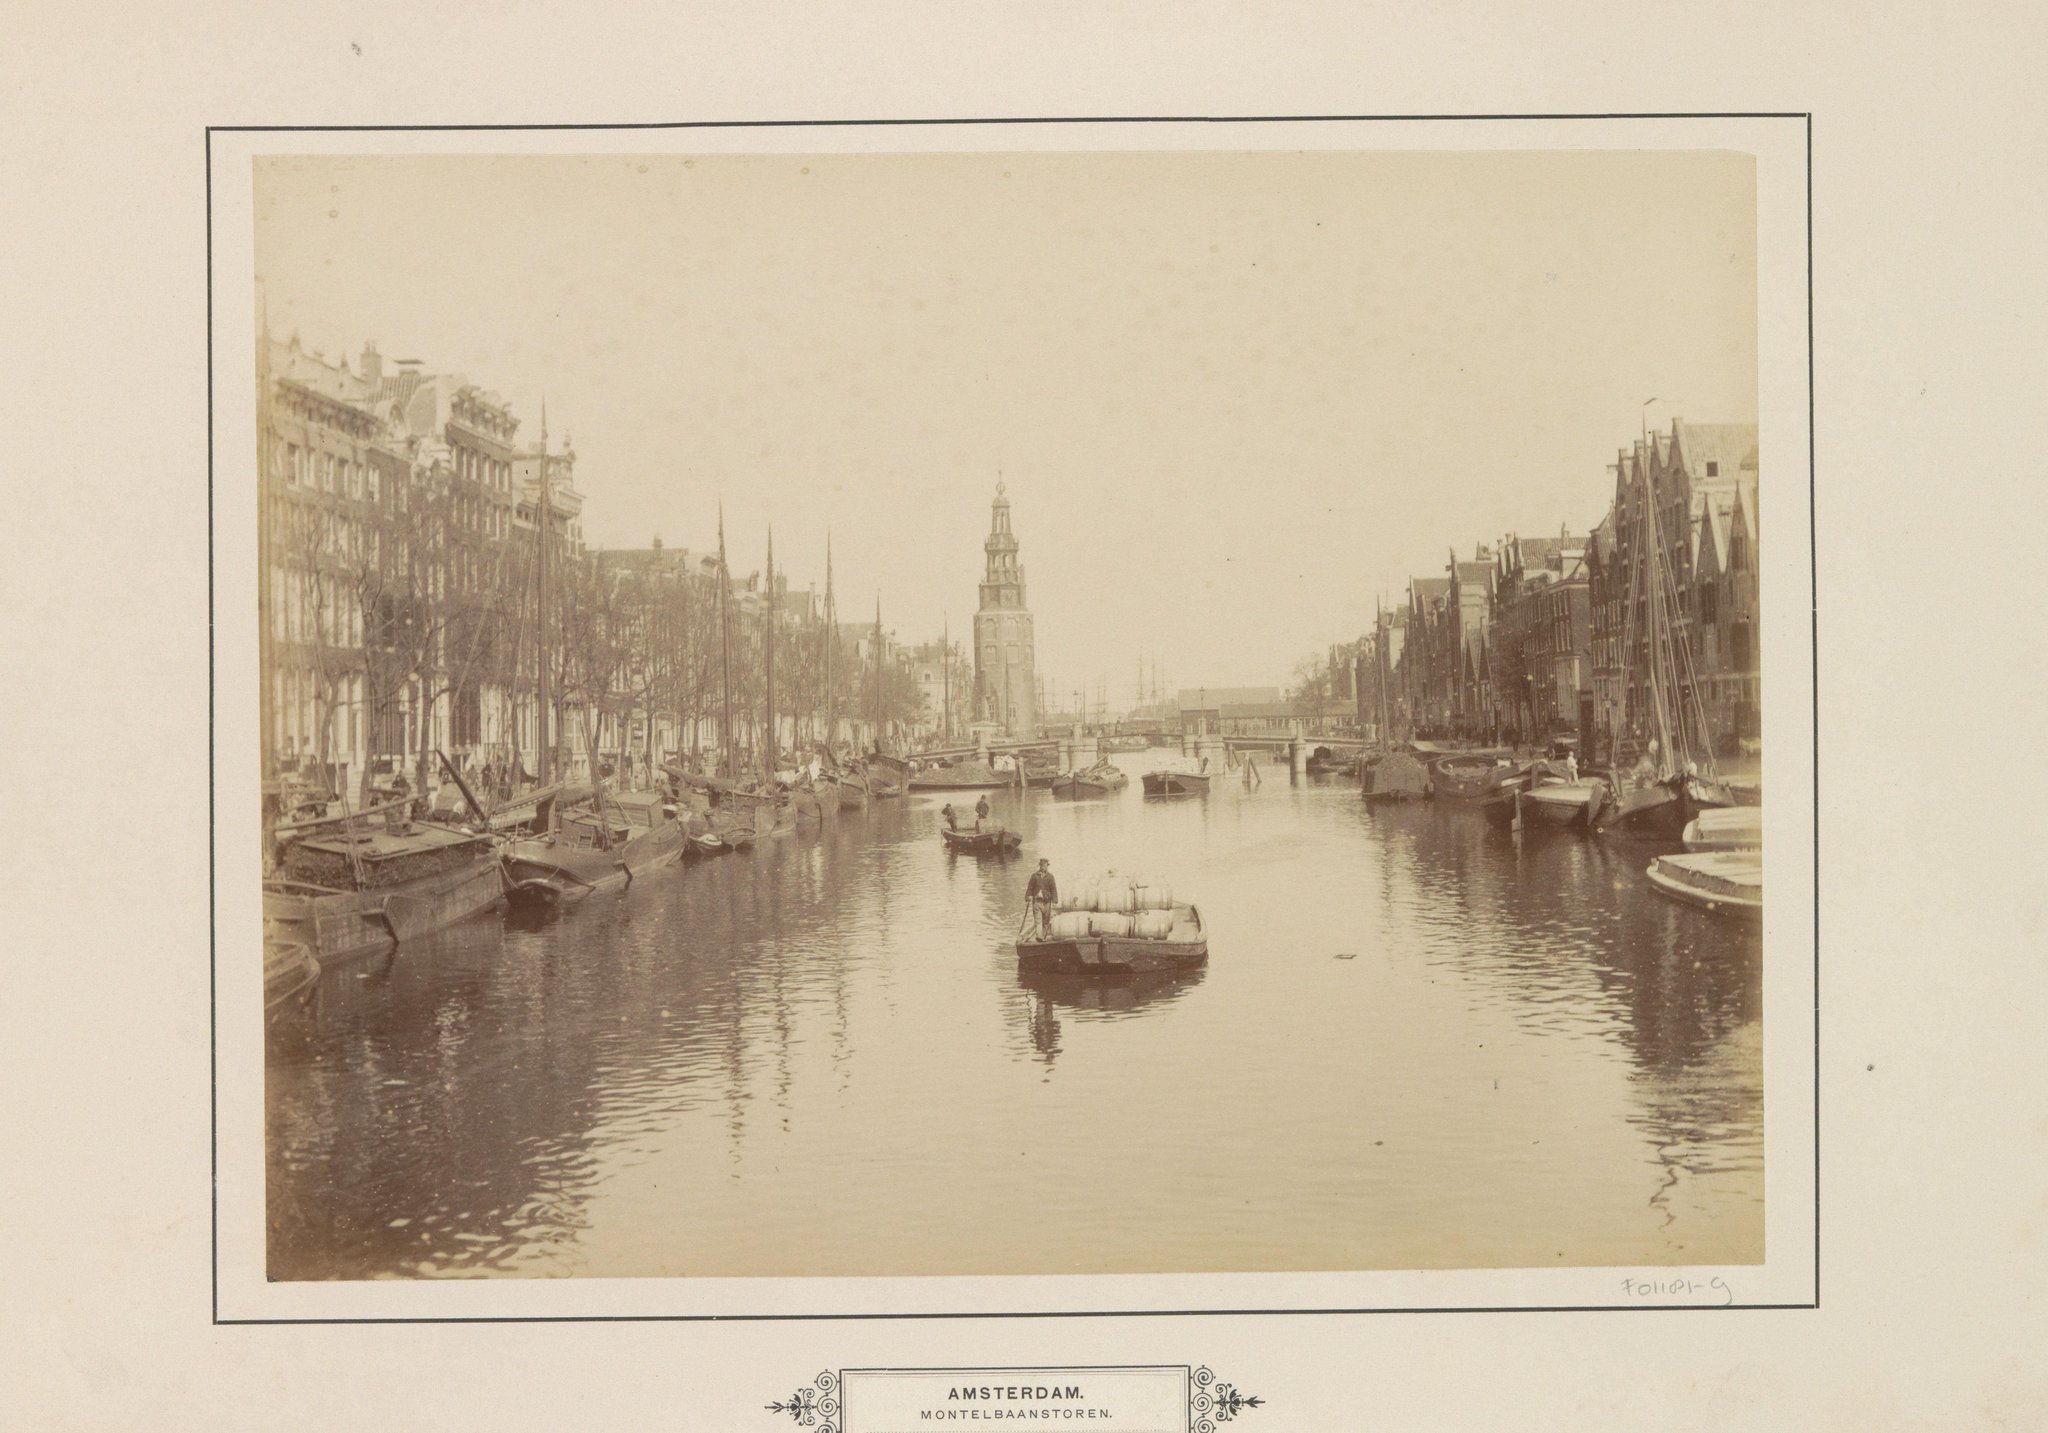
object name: photograph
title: Oudeschans met aan de horizon de Montelbaanstoren, gezien in noordelijke richting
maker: Anonymous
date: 1880-1895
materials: photographic support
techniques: albumen print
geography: amsterdam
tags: towers ~ fortified city, freight vessel, canal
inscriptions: inscription: ‘Hendrik Groote Kalverstraat 43, Amsterdam. Photographic stores. Views from Holland. Photographs from ancient and modern dutch Paintings. Fines ans most complete Collection.’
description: Onderdeel van Fotoalbum met opnames van het centrum van Amsterdam en reclameteksten voor winkels en bedrijven.